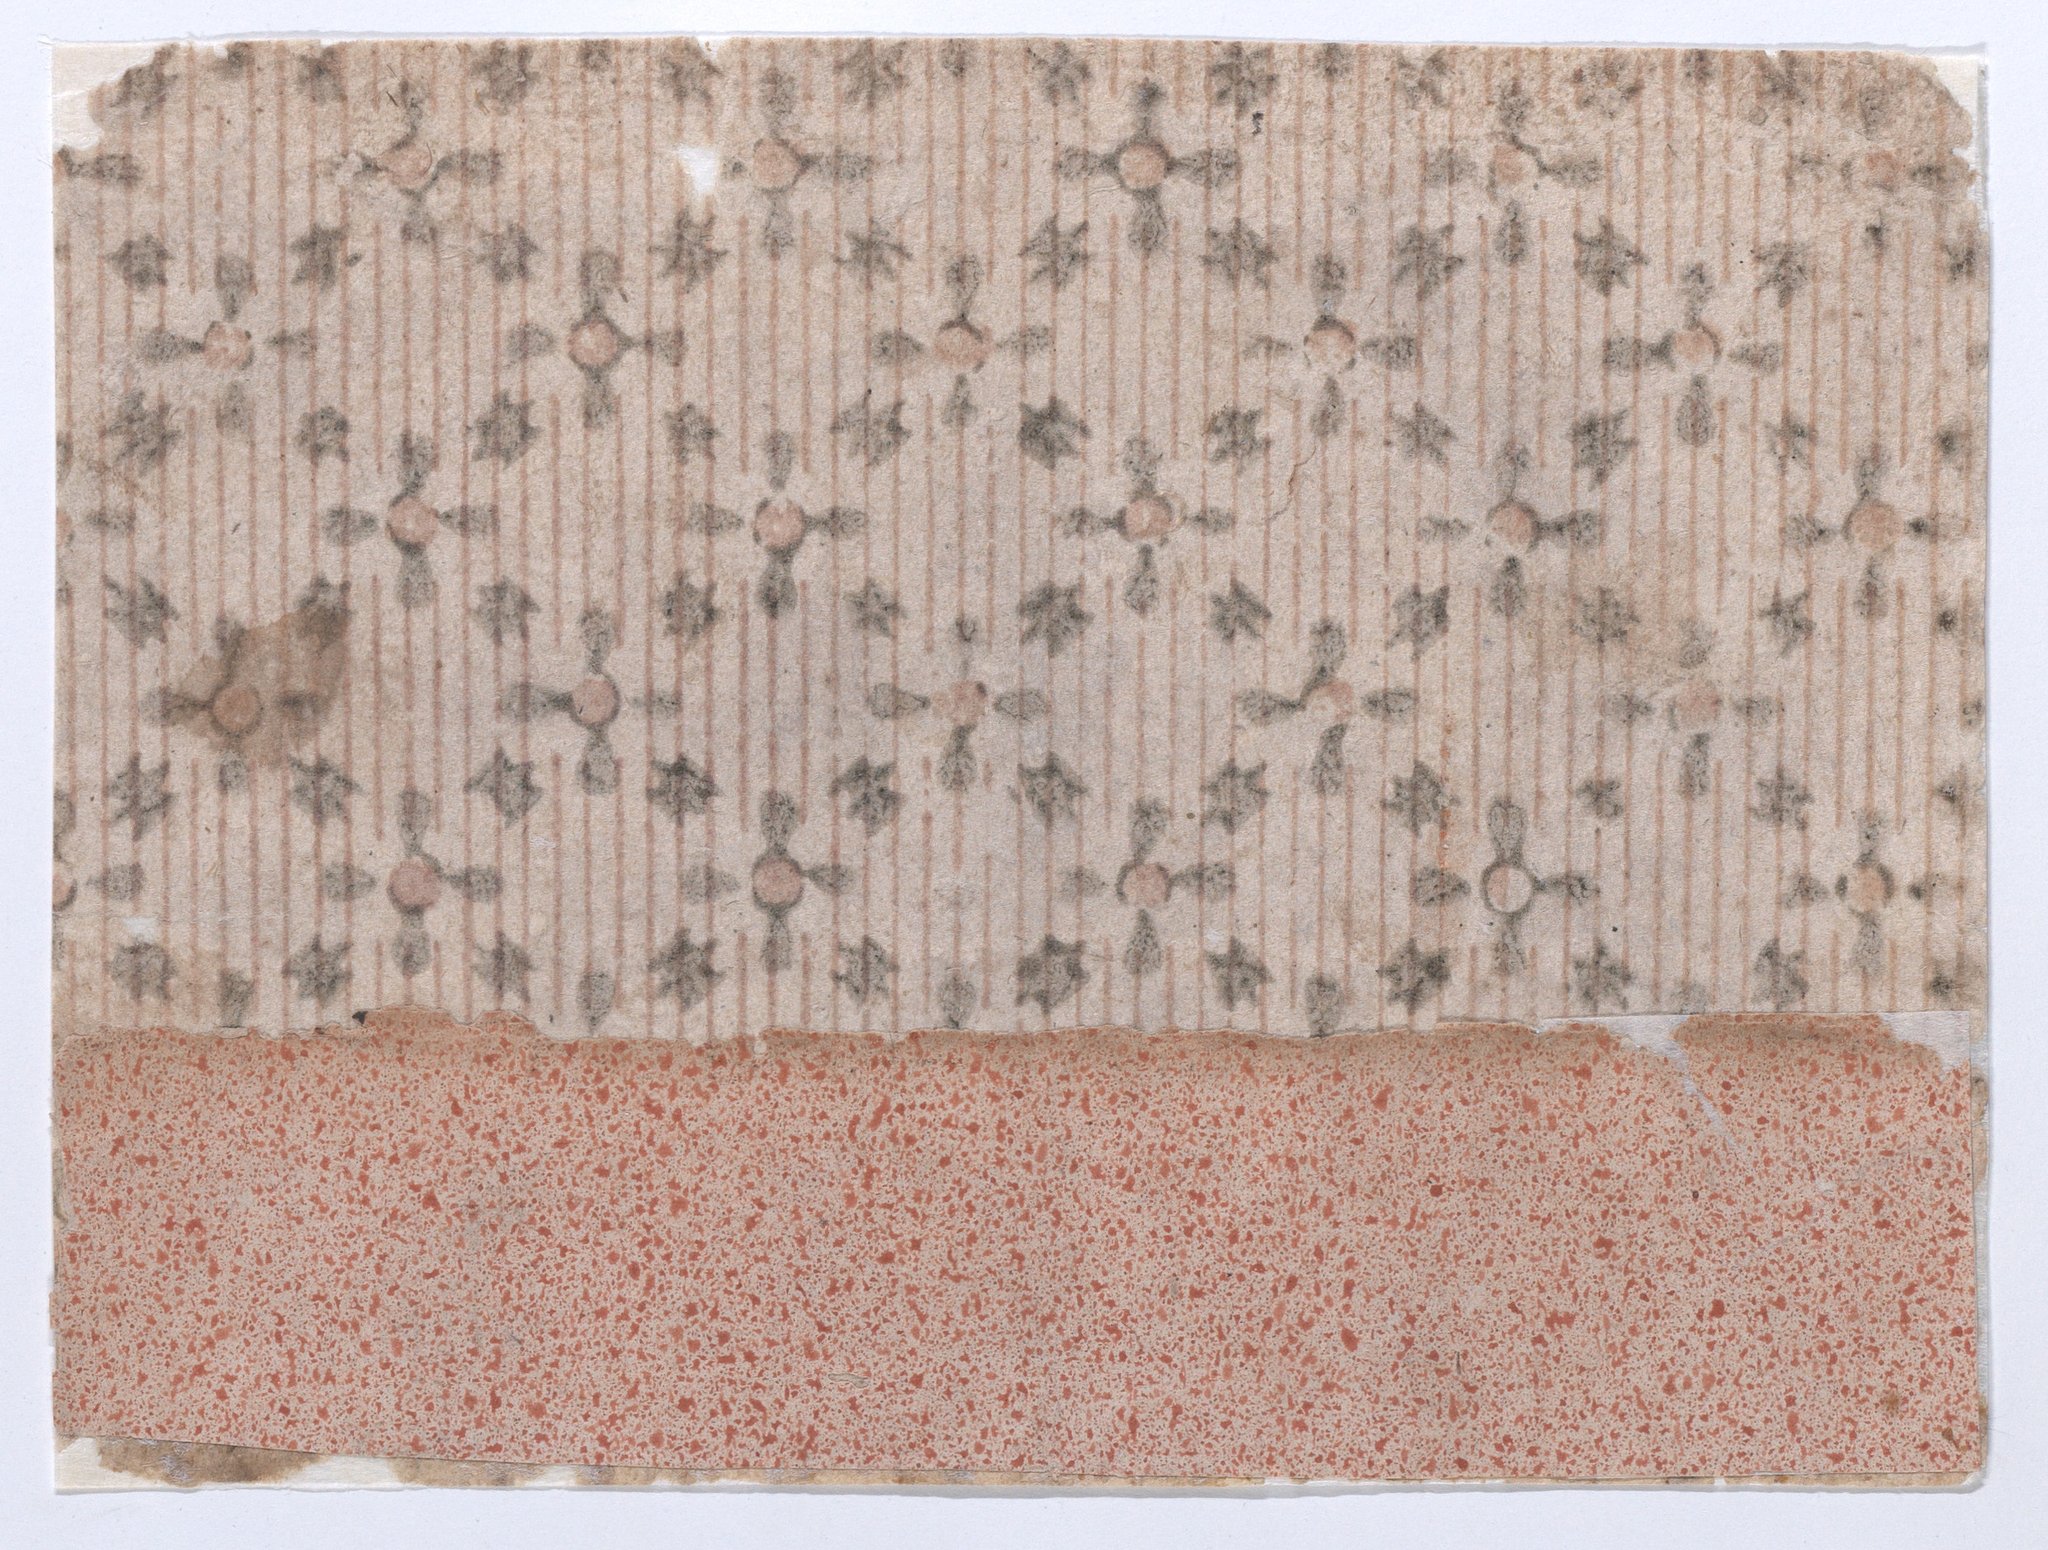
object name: print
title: Sheet with stripe and abstract pattern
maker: Anonymous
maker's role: artist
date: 1801-1900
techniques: relief print